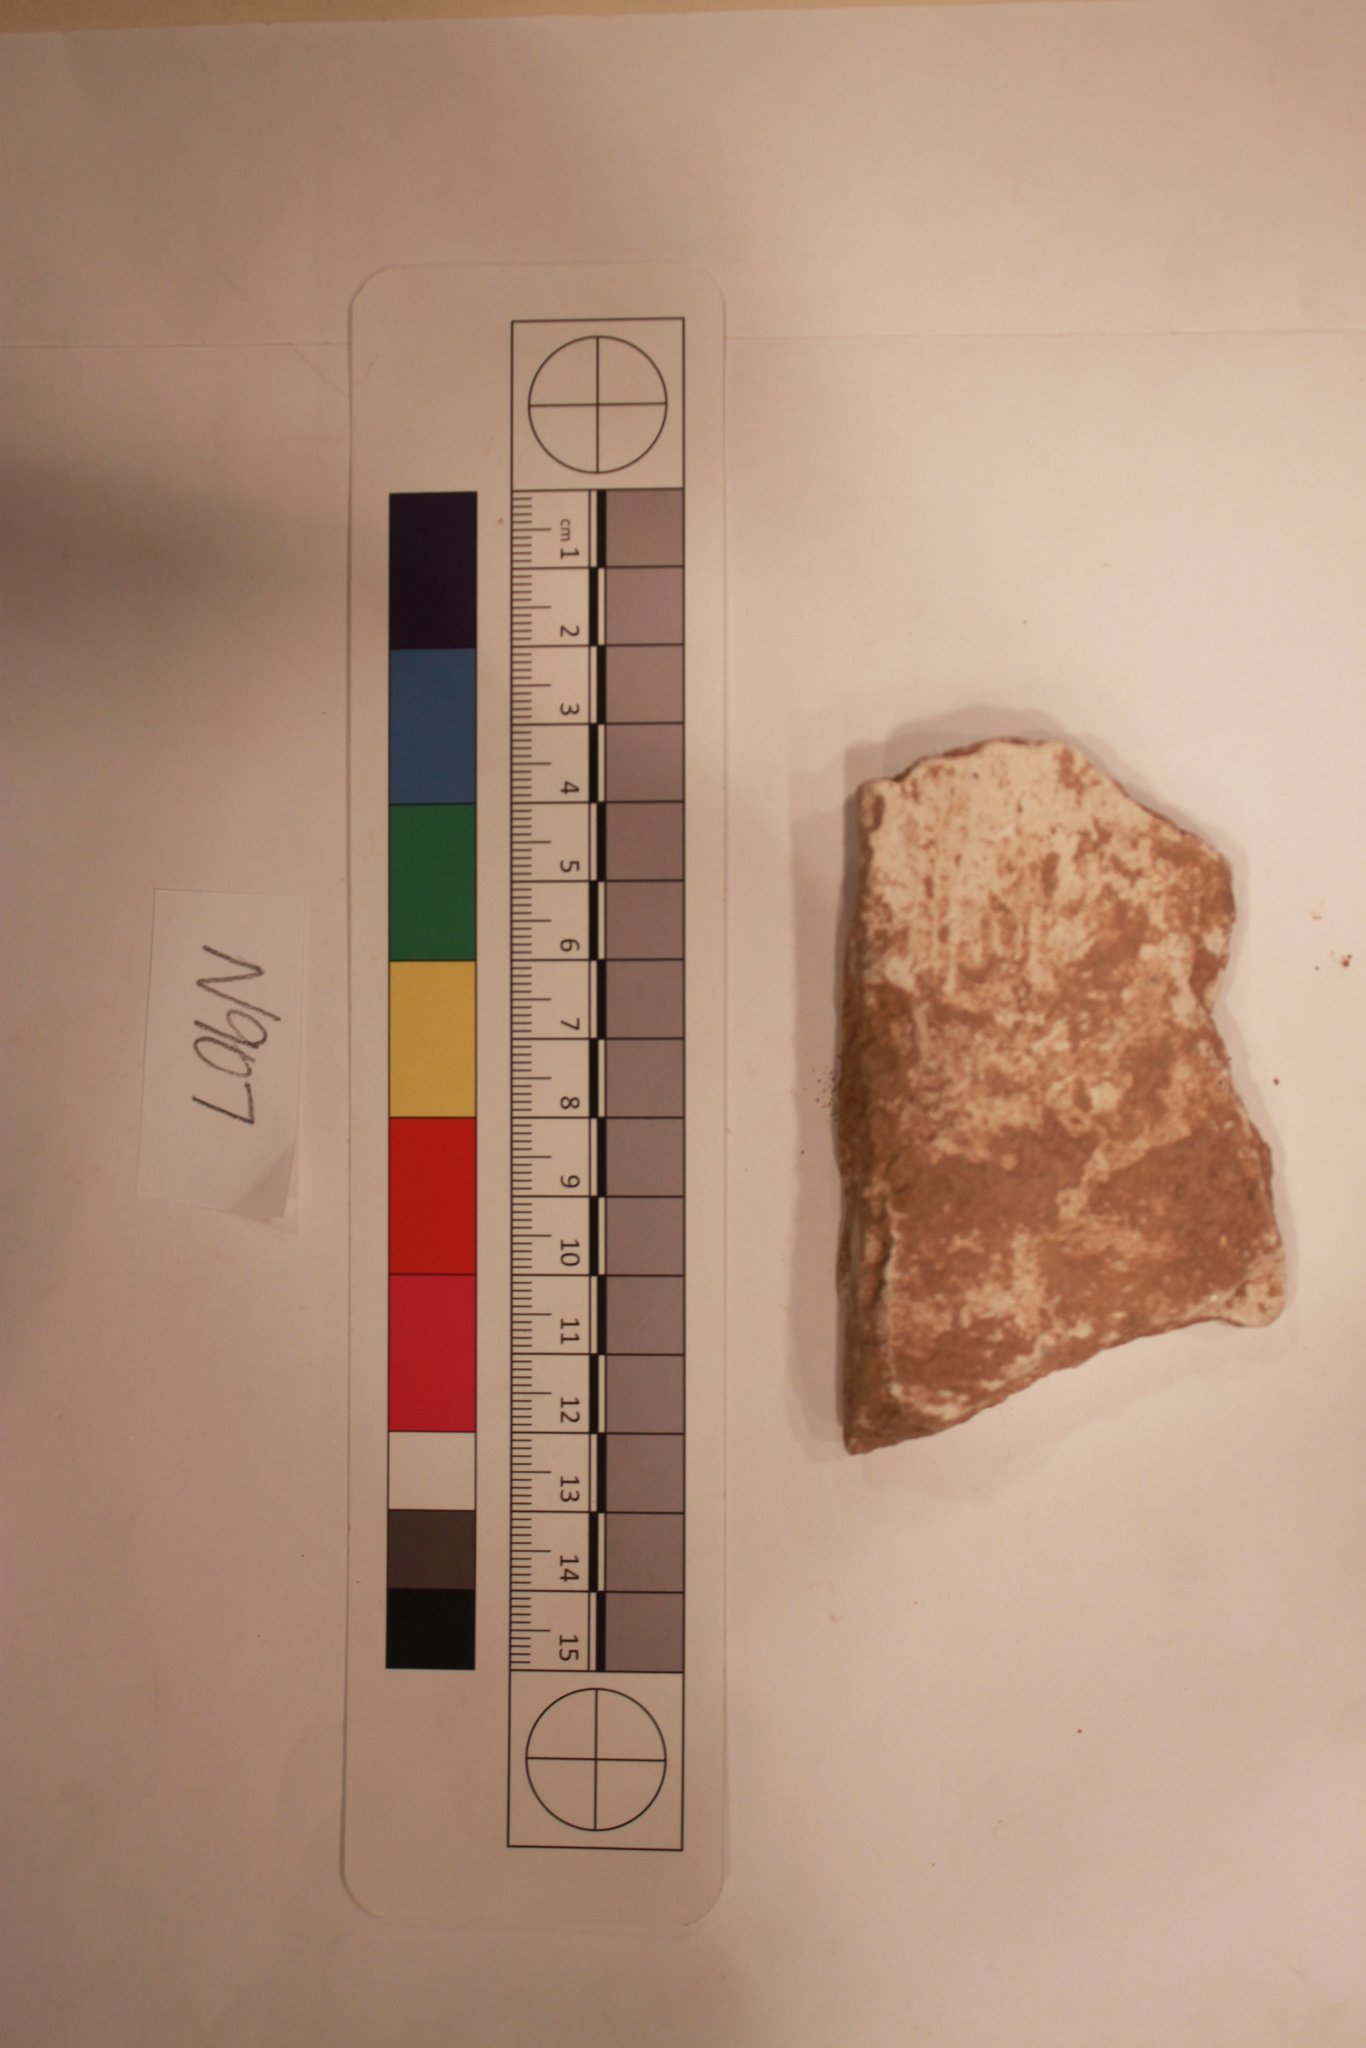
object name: fragment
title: Stucco Fragment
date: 701-1200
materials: plaster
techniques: carving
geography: iran